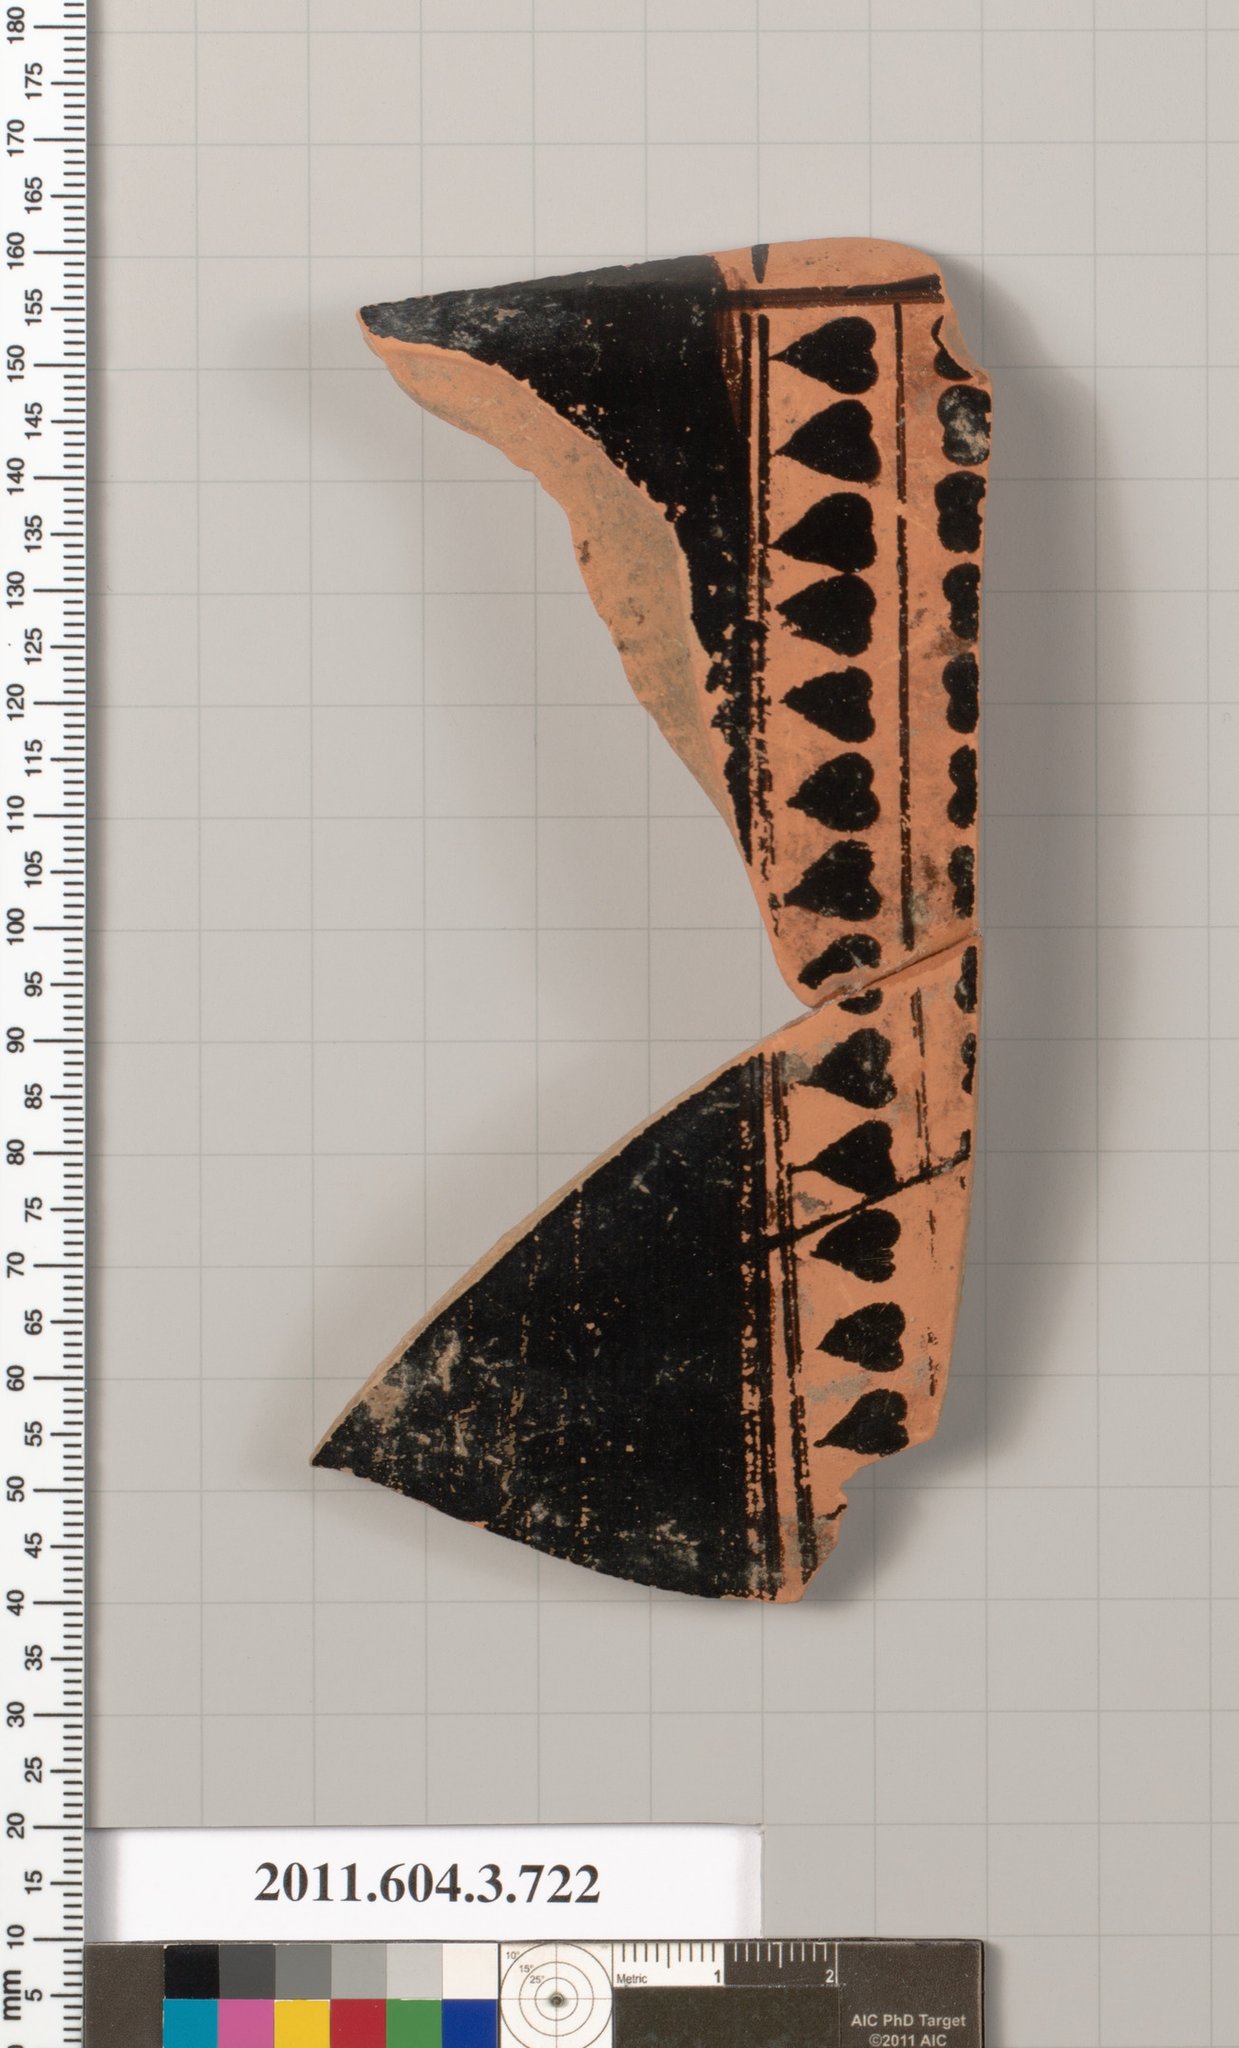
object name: hydria fragment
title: Terracotta fragment of a hydria (water jar)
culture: greek, attic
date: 534-468 BCE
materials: terracotta